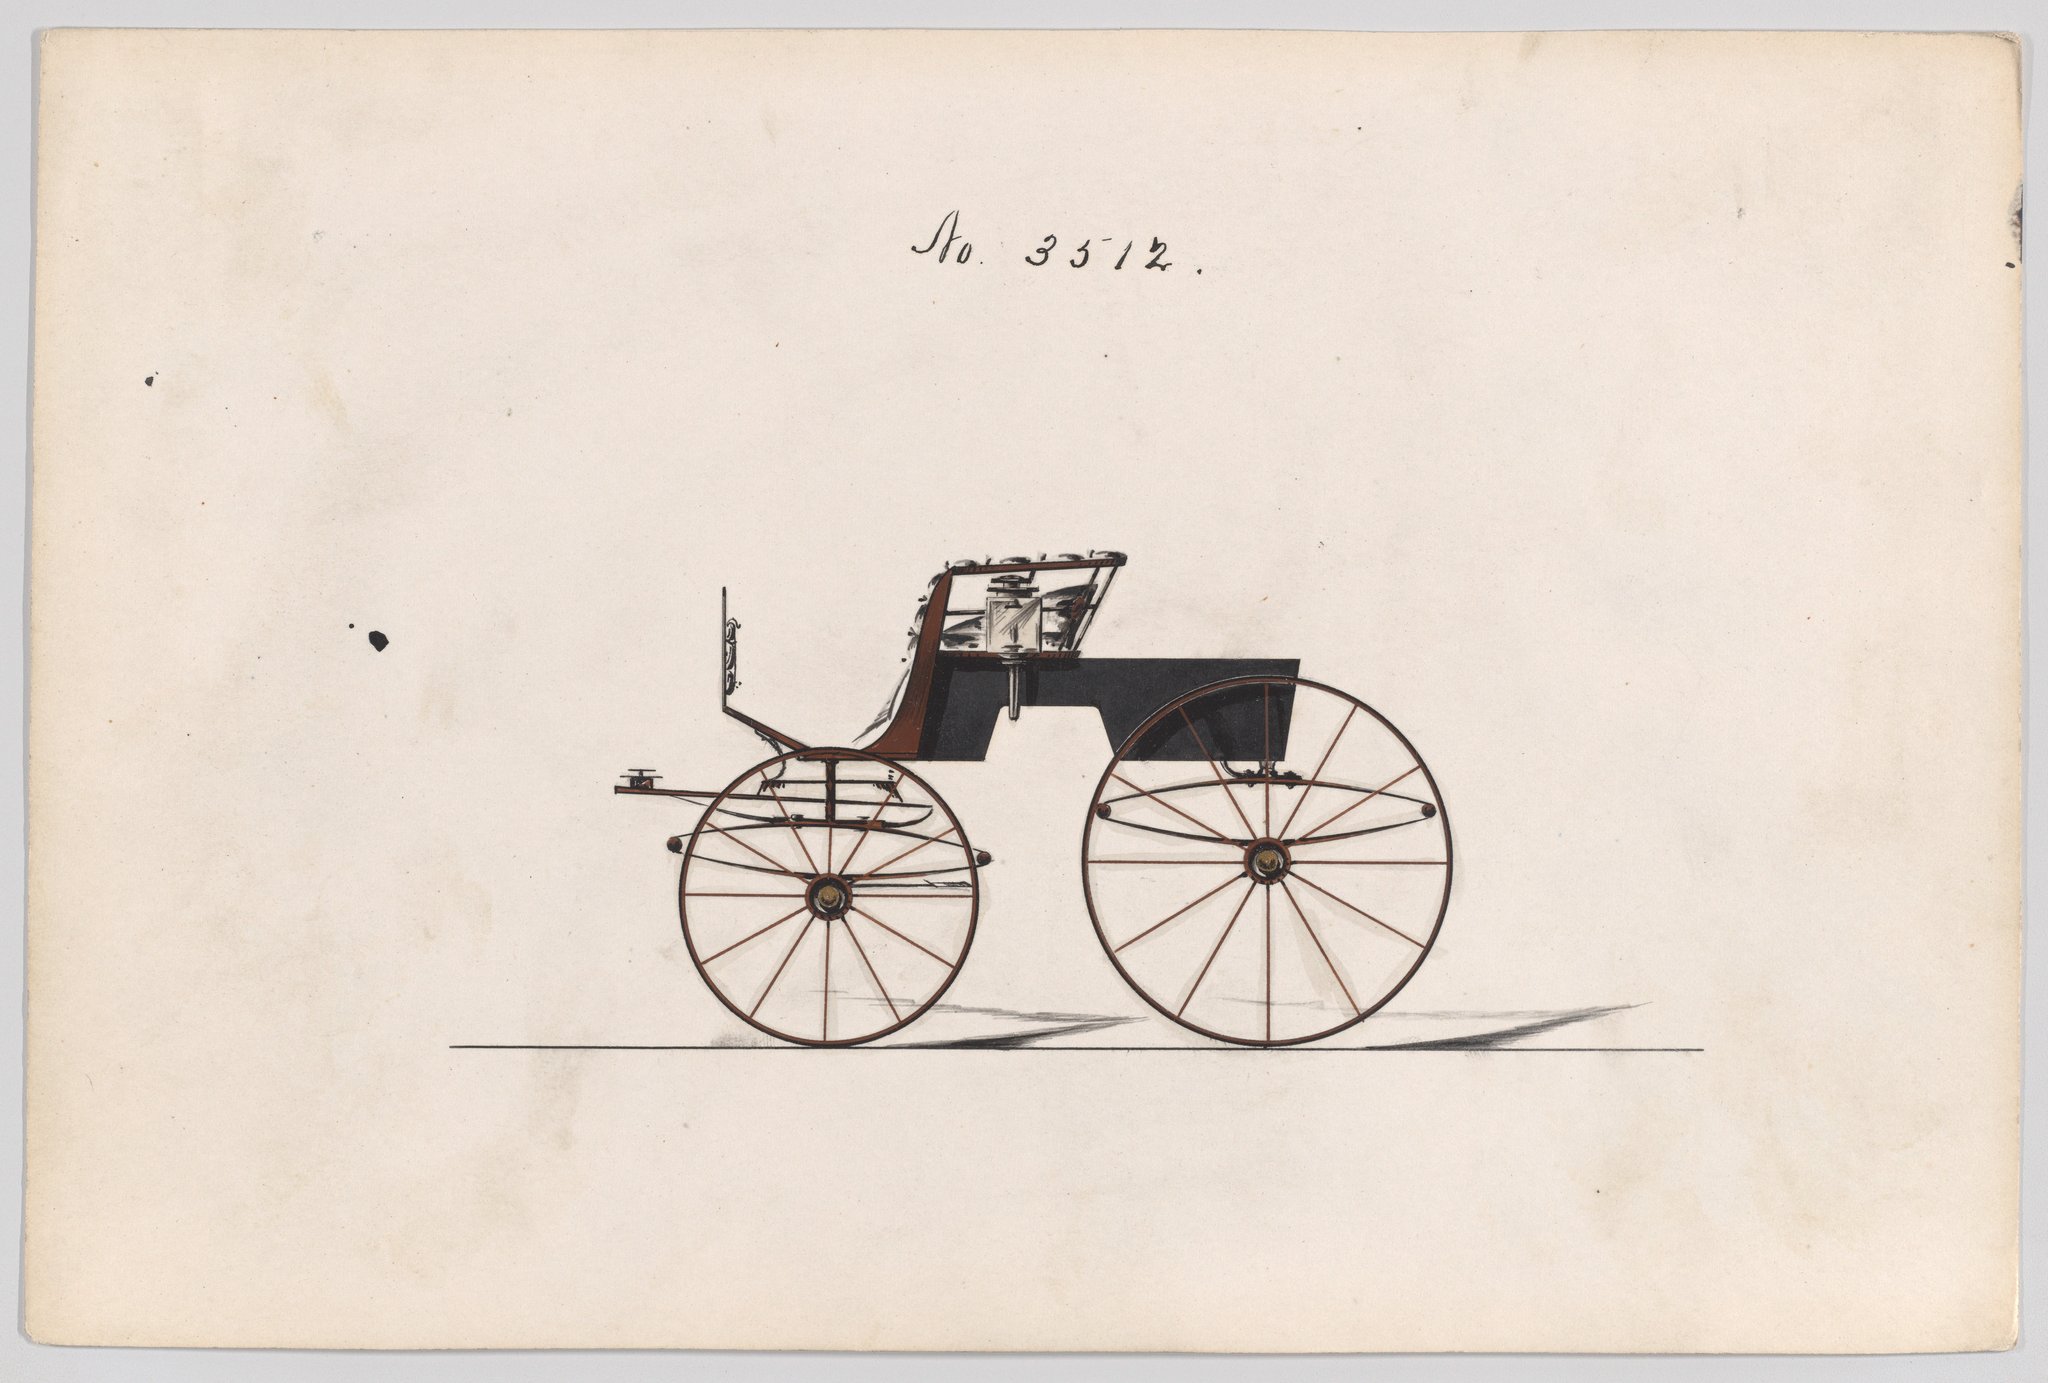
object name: drawing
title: Design for T-Cart, no. 3512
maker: brewster & co.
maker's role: manufacturer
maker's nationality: american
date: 1879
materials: gouache, gum arabic, ink, watercolor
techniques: pen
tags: carriages